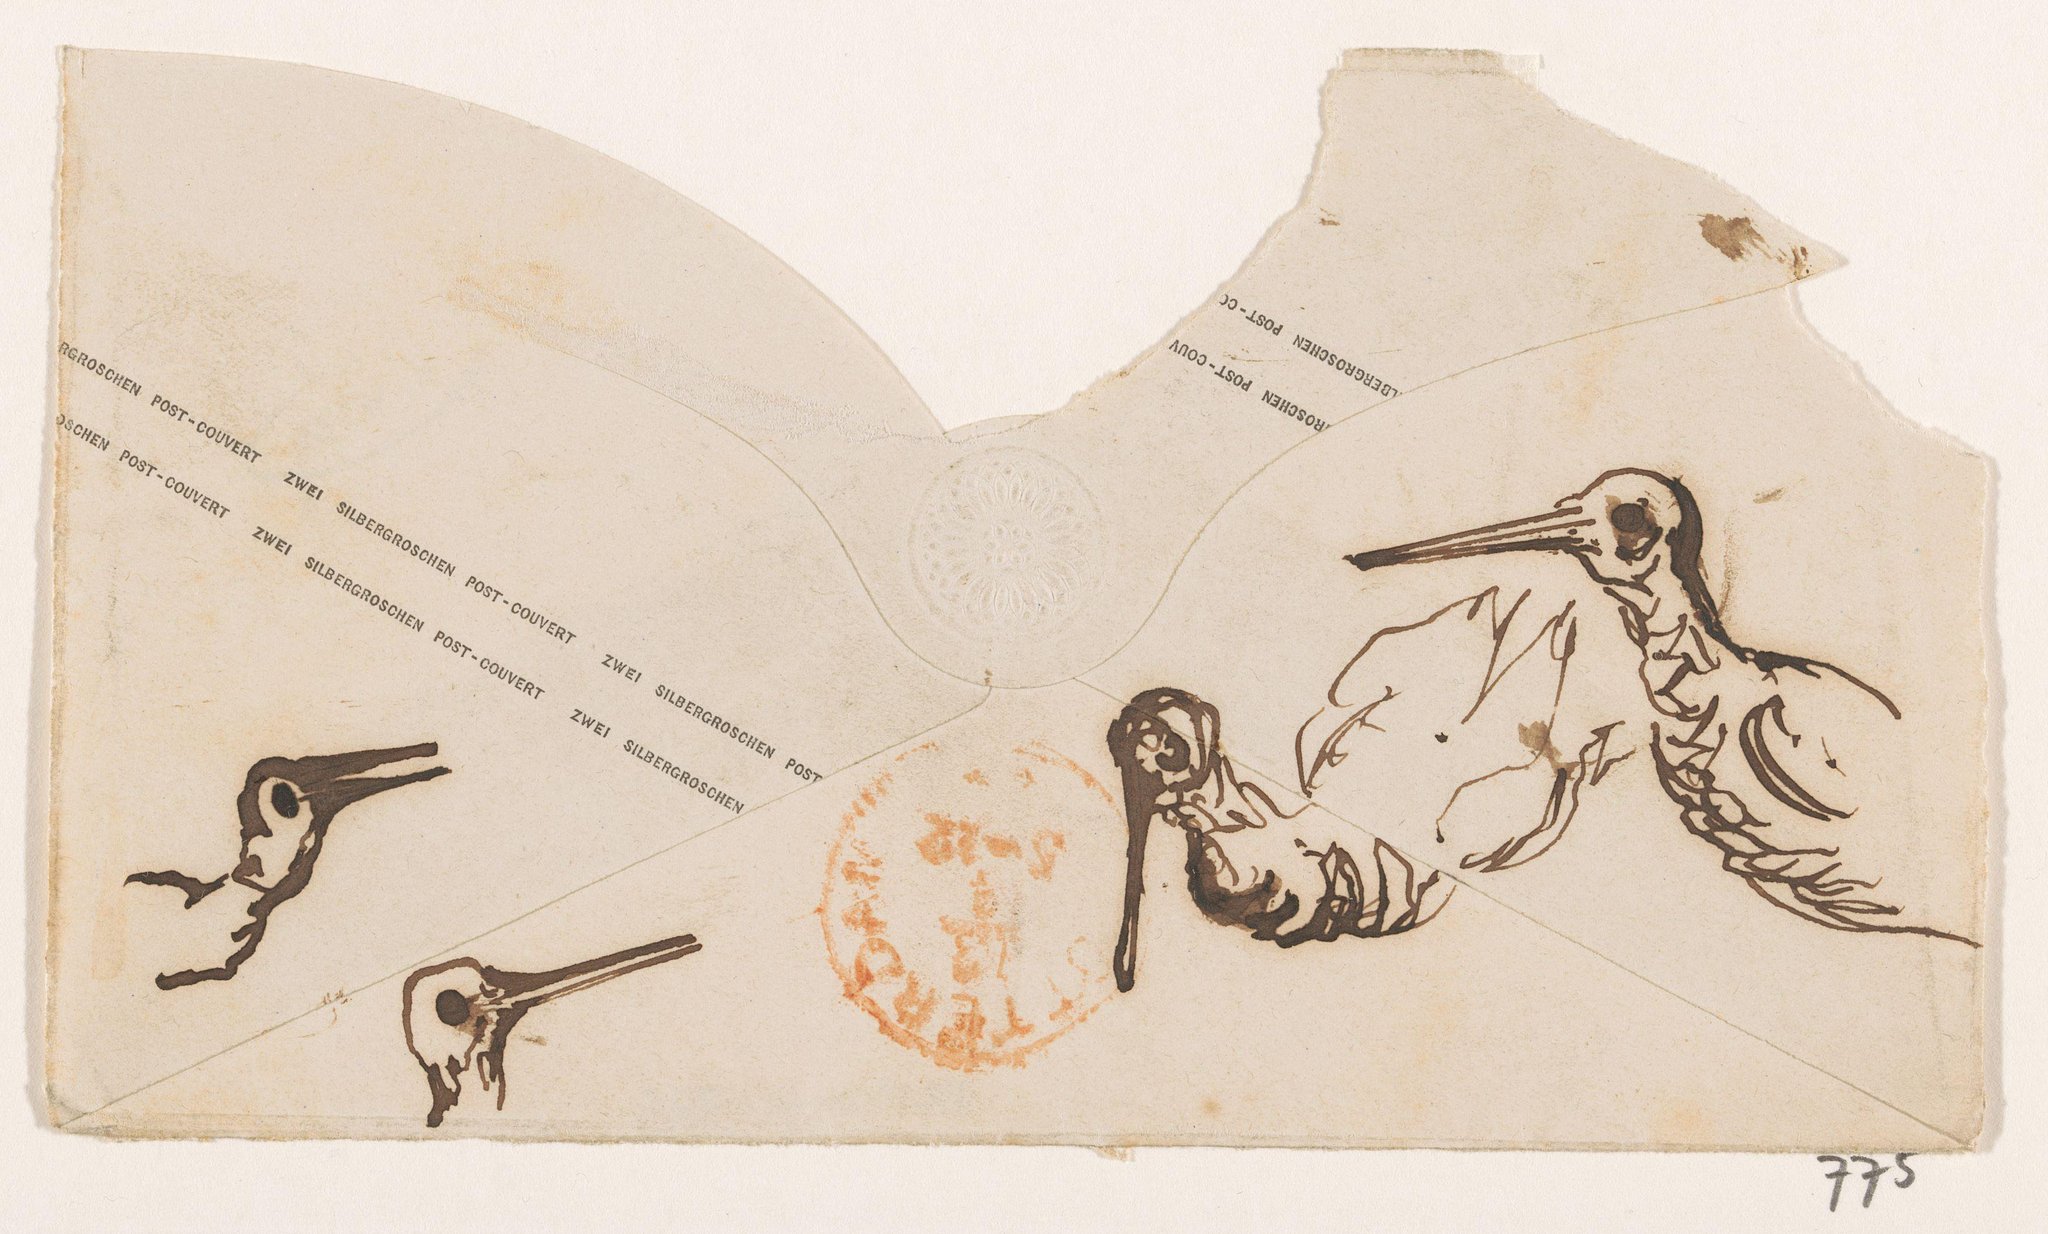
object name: drawing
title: Koppen van watervogels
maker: johannes tavenraat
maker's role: draughtsman, painter, print maker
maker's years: 1809-1881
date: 1840-1880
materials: ink, paper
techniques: pen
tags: water-birds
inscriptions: collector's mark: Lugt 2228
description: Koppen van watervogels. Getekend op de achterzijde van een deel van een envelop met poststempel (datum onleesbaar).